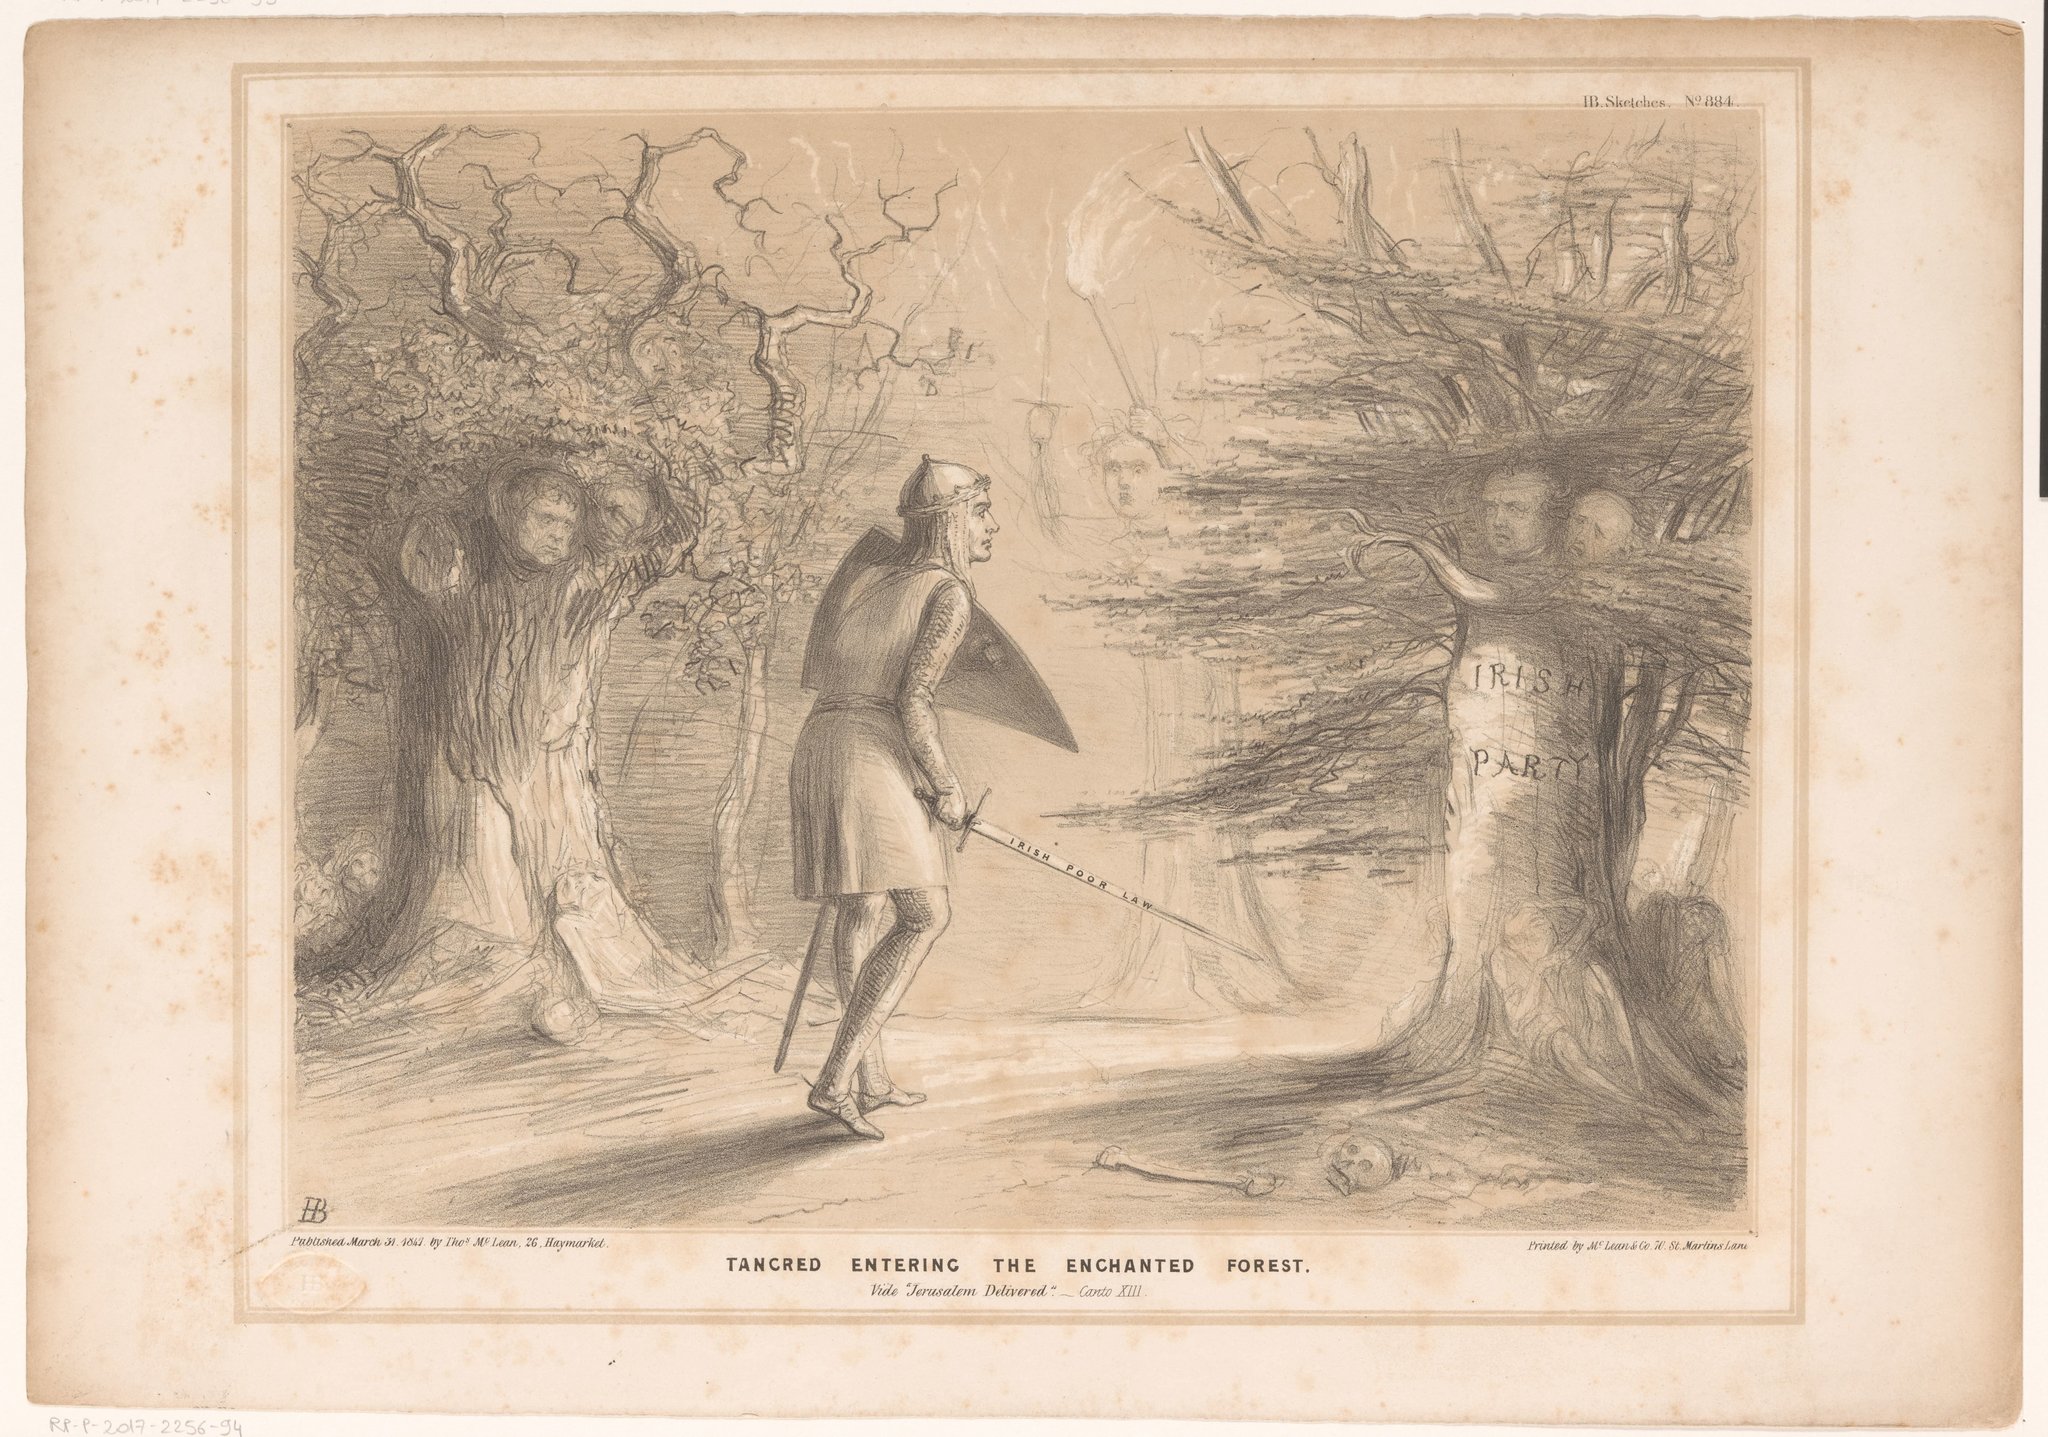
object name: print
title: HB Sketches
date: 1847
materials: paper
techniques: tone lithography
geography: london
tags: politician, tancred, (scenes from) specific works of literature: tasso, gerusalemme liberata, political caricatures and satires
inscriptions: stamp: ‘HB Subscribers Copy’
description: Spotprent uit 1847 met Lord Russell als de ridder Tancredi in het betoverde woud in Tasso's La Gerusalemme liberata. De bomen hebben de hoofden van politici waaronder de Ier Daniel O'Connell. Uitgegeven als nr. 884 in de serie HB Sketches.